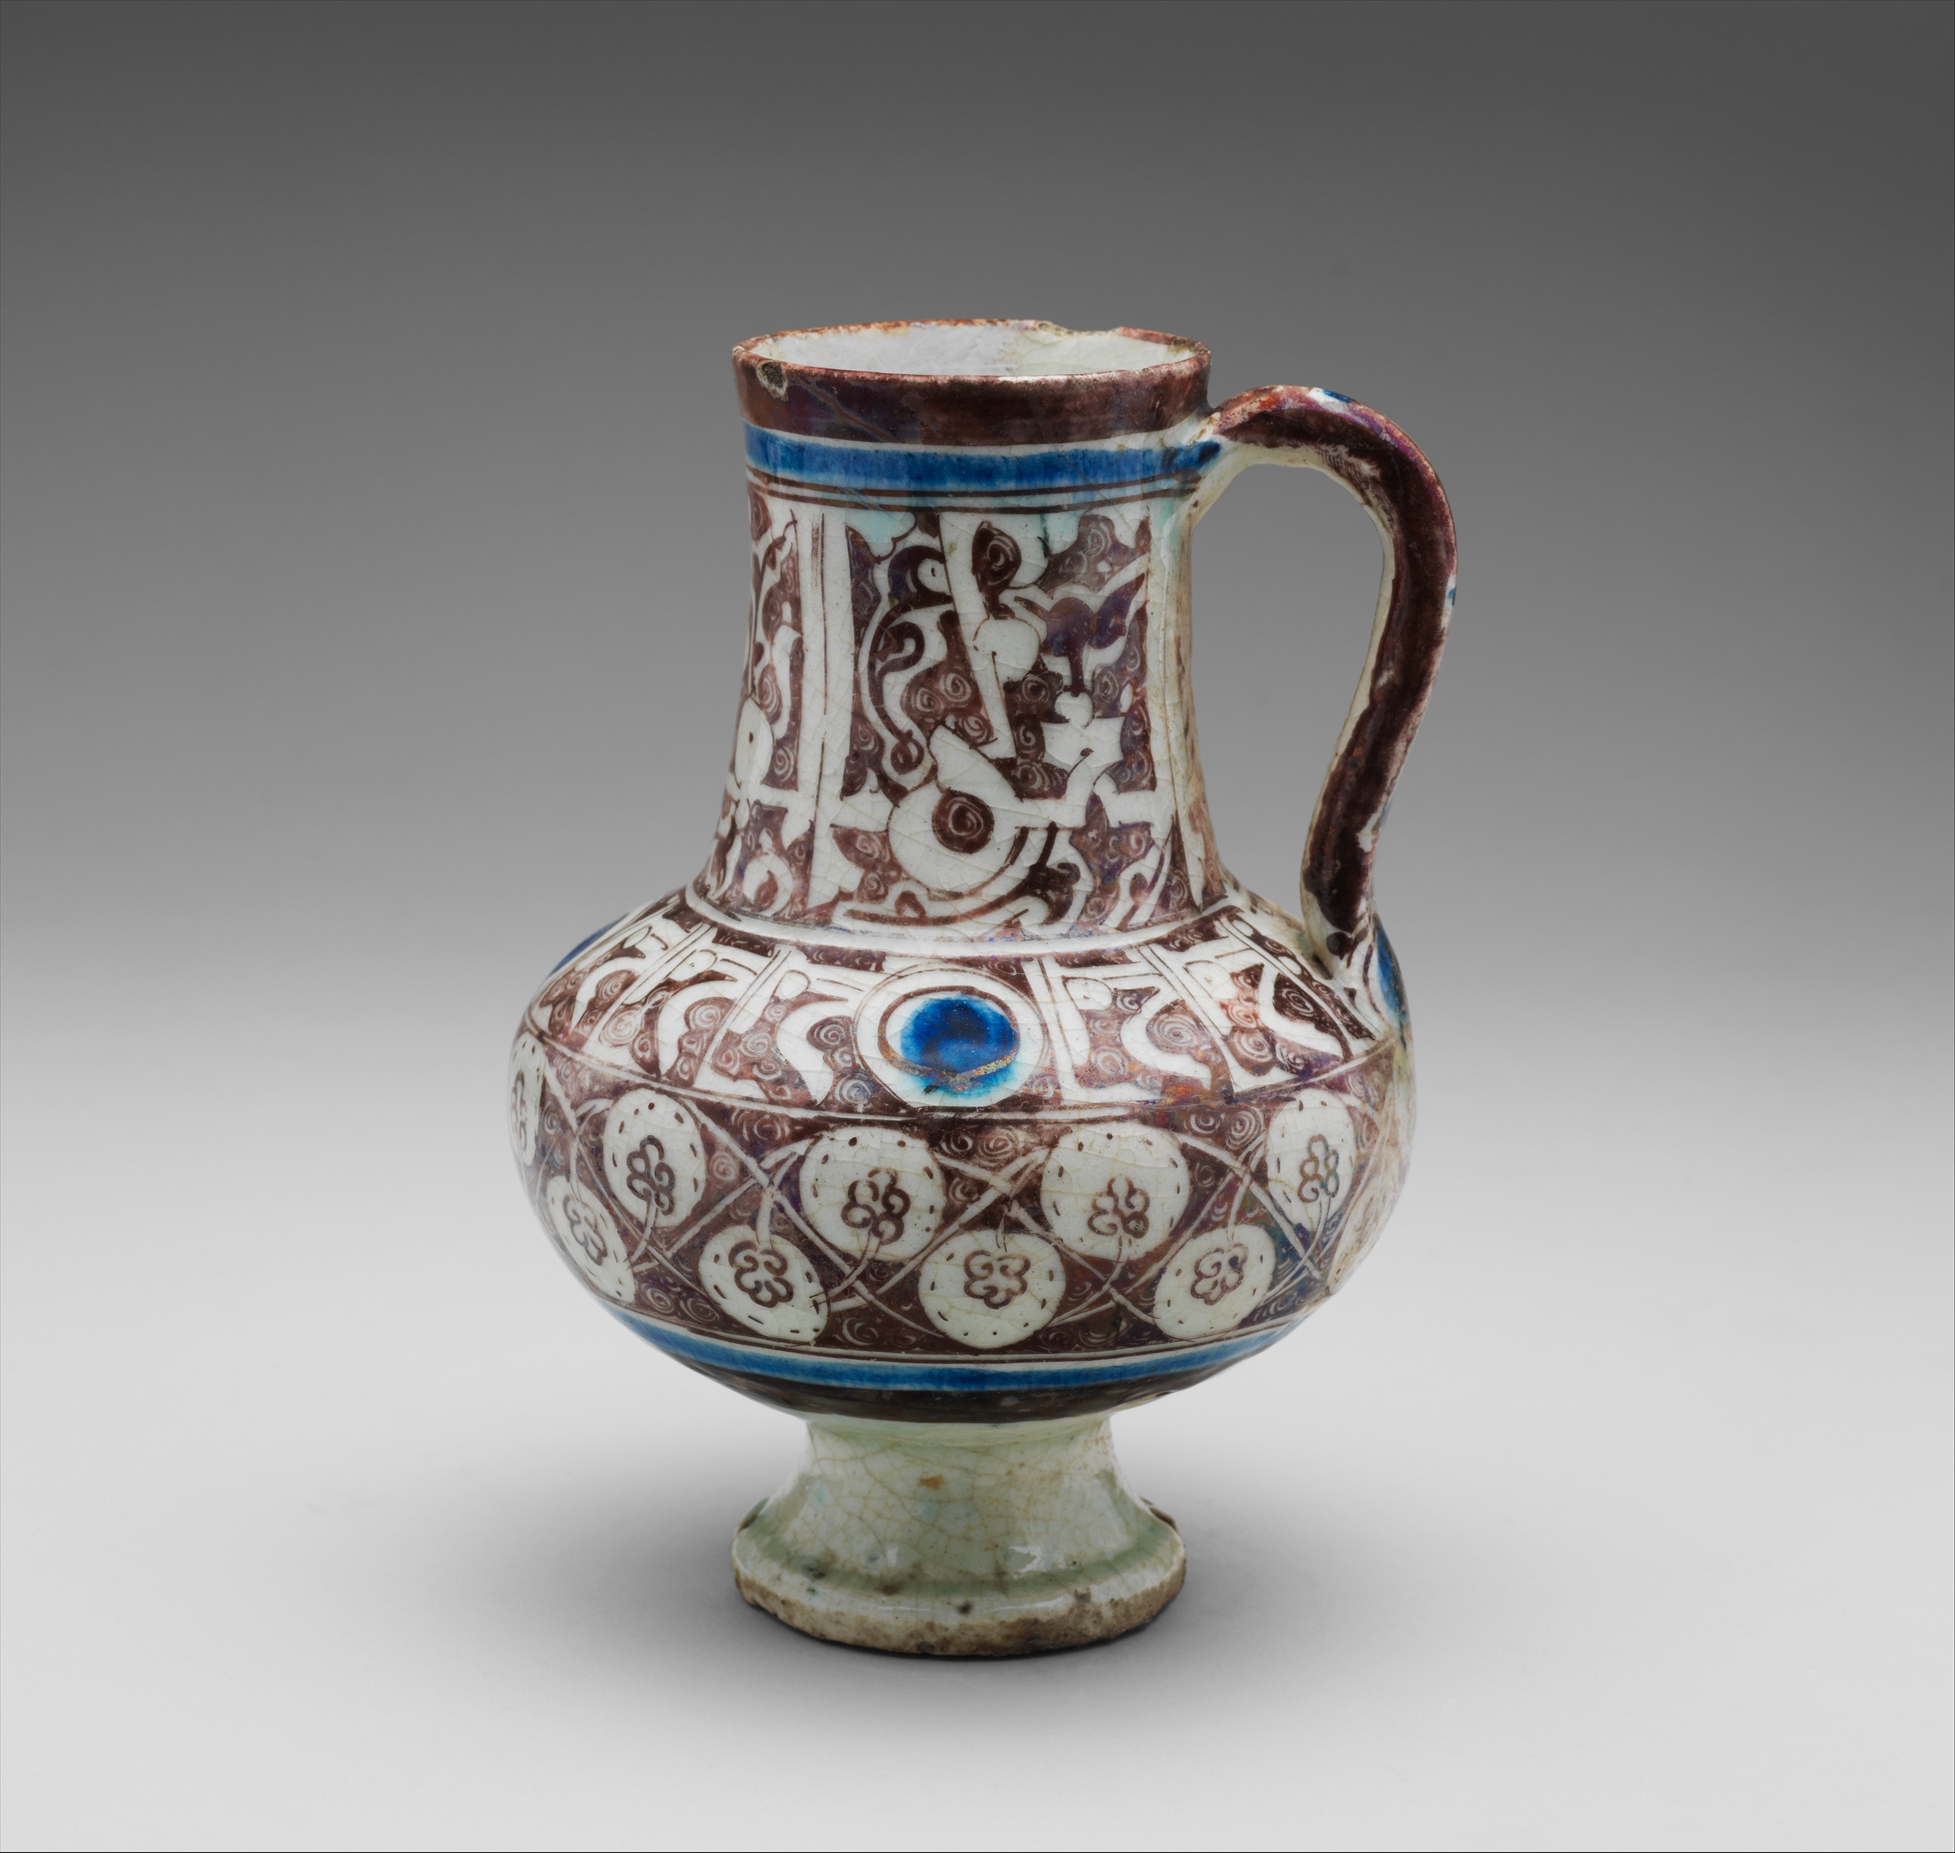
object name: ewer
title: Ewer Inscribed with "al-'izz" ("Glory") in Floriated Kufic on its Neck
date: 1201-1250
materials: glaze, stonepaste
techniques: painting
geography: syria